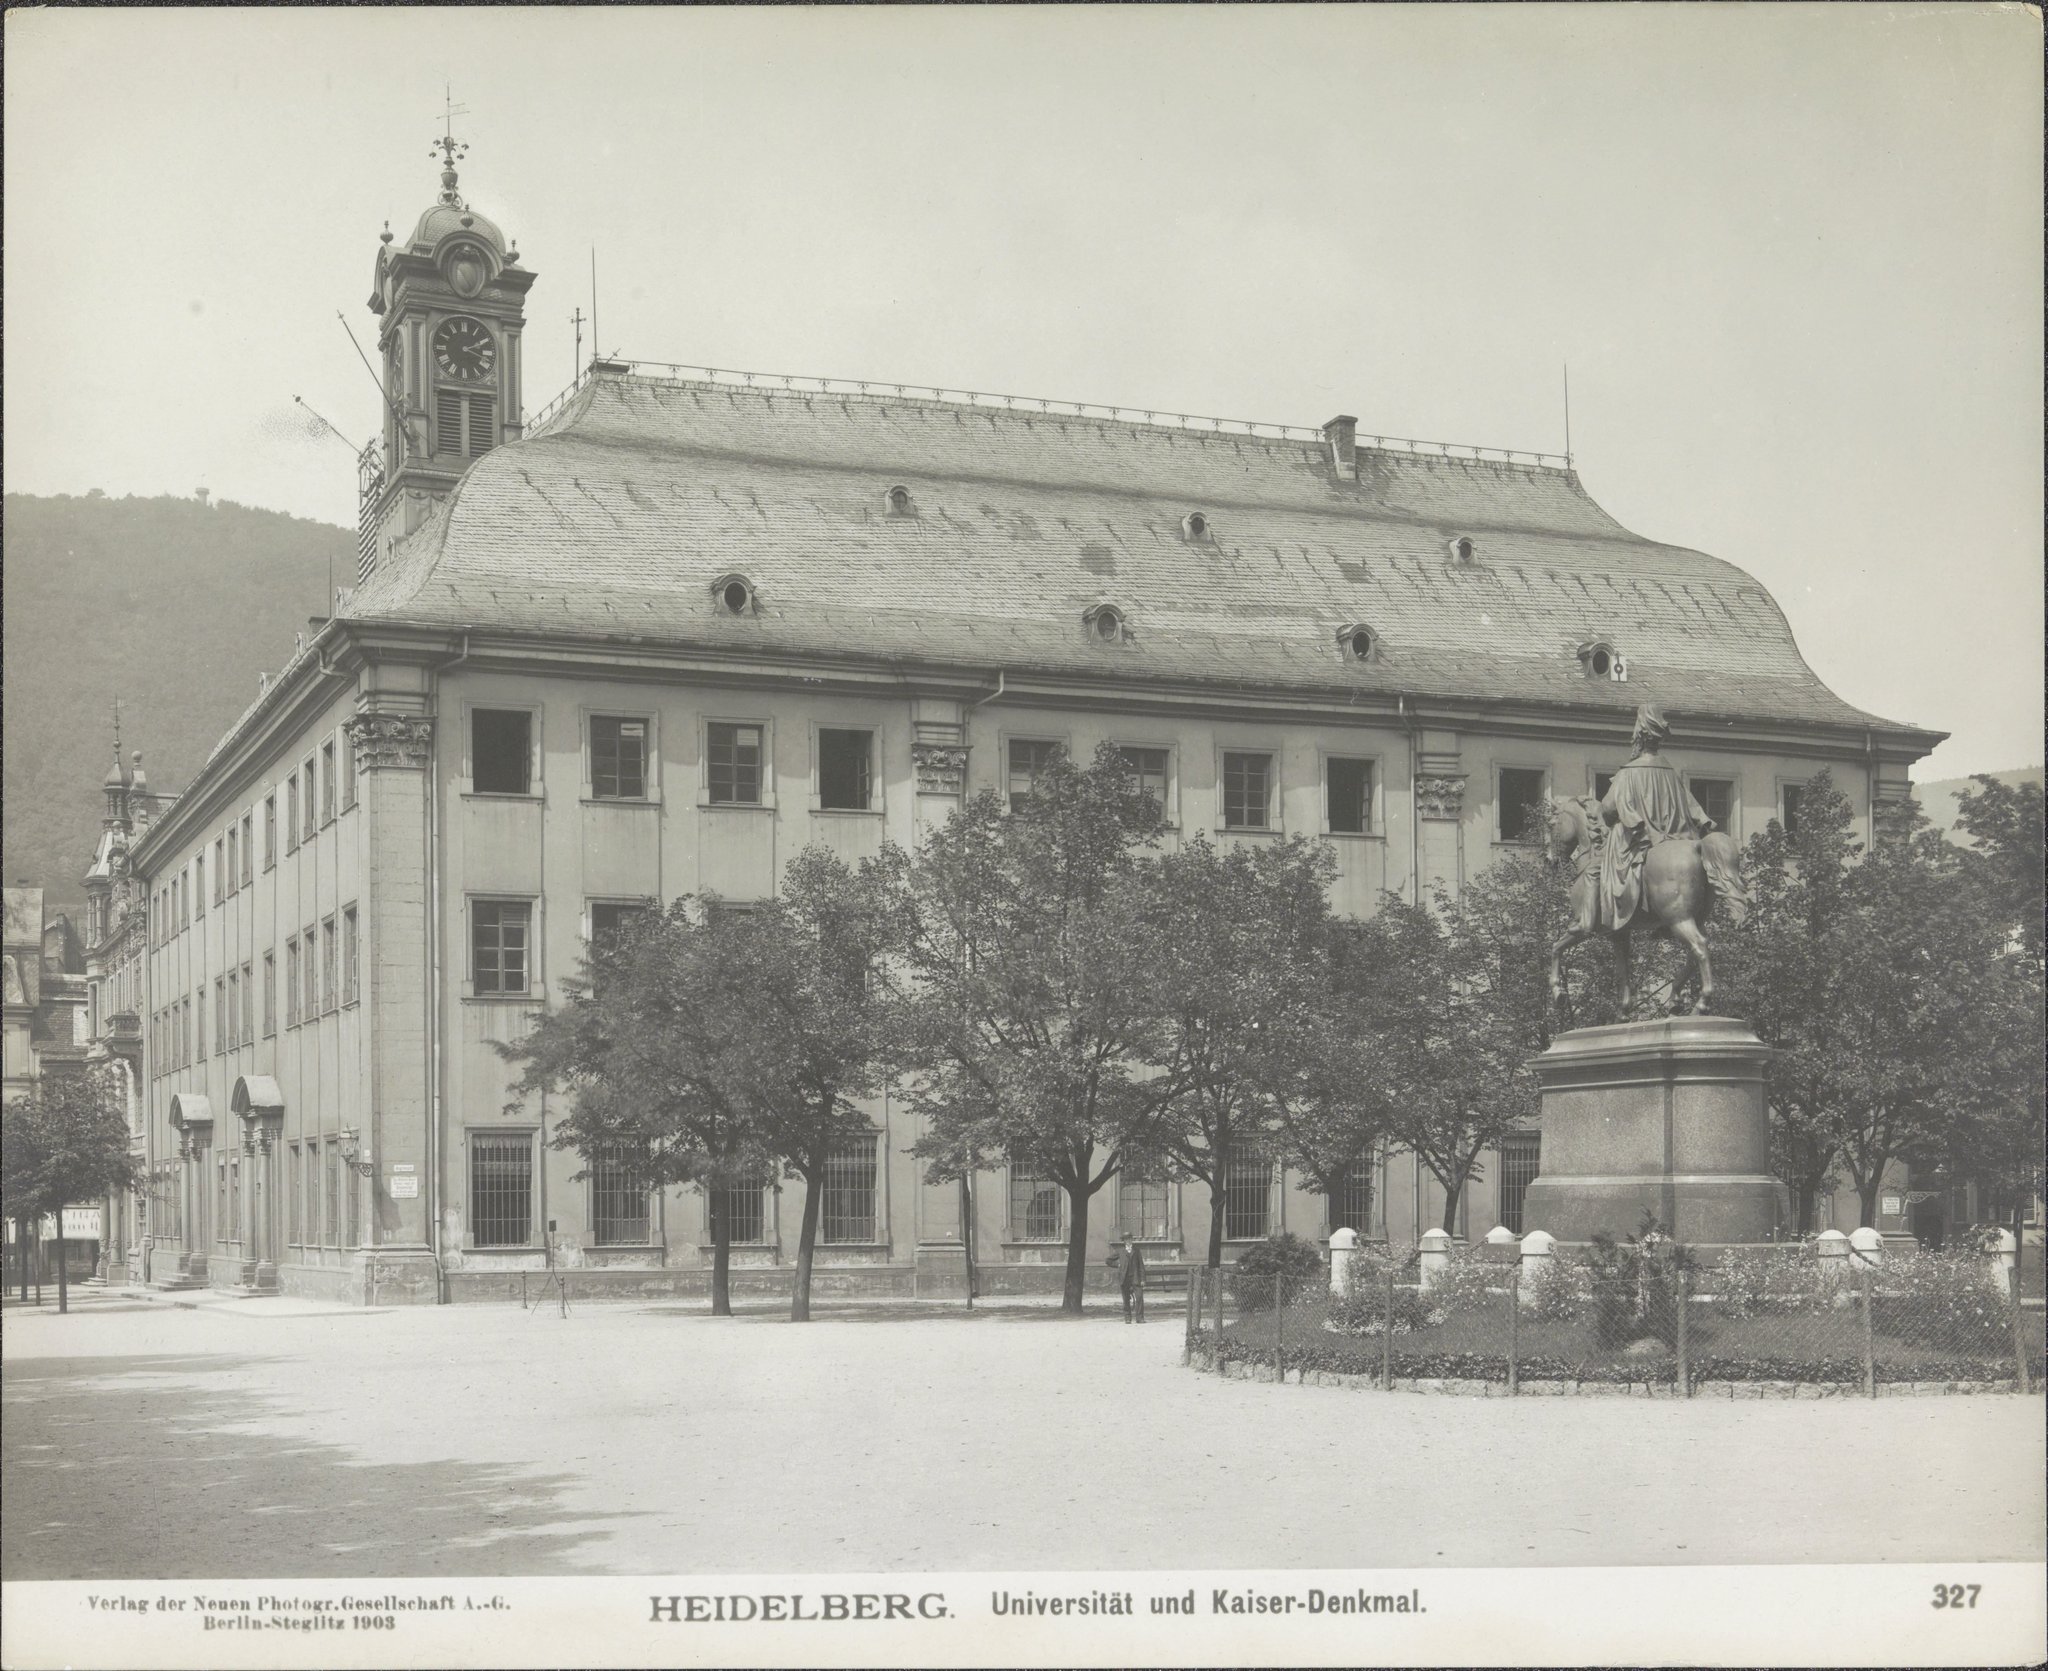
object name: photograph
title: Heidelberg. Universität und Kaiser-Denkmal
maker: Anonymous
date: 1903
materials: photographic support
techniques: gelatin silver print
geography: heidelberg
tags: equestrian statue, university building, college, prospect of city, town panorama, silhouette of city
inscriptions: number: ‘327’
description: Onderdeel van Fotoalbum met opnames van Heidelberg en Schloss Heidelberg.